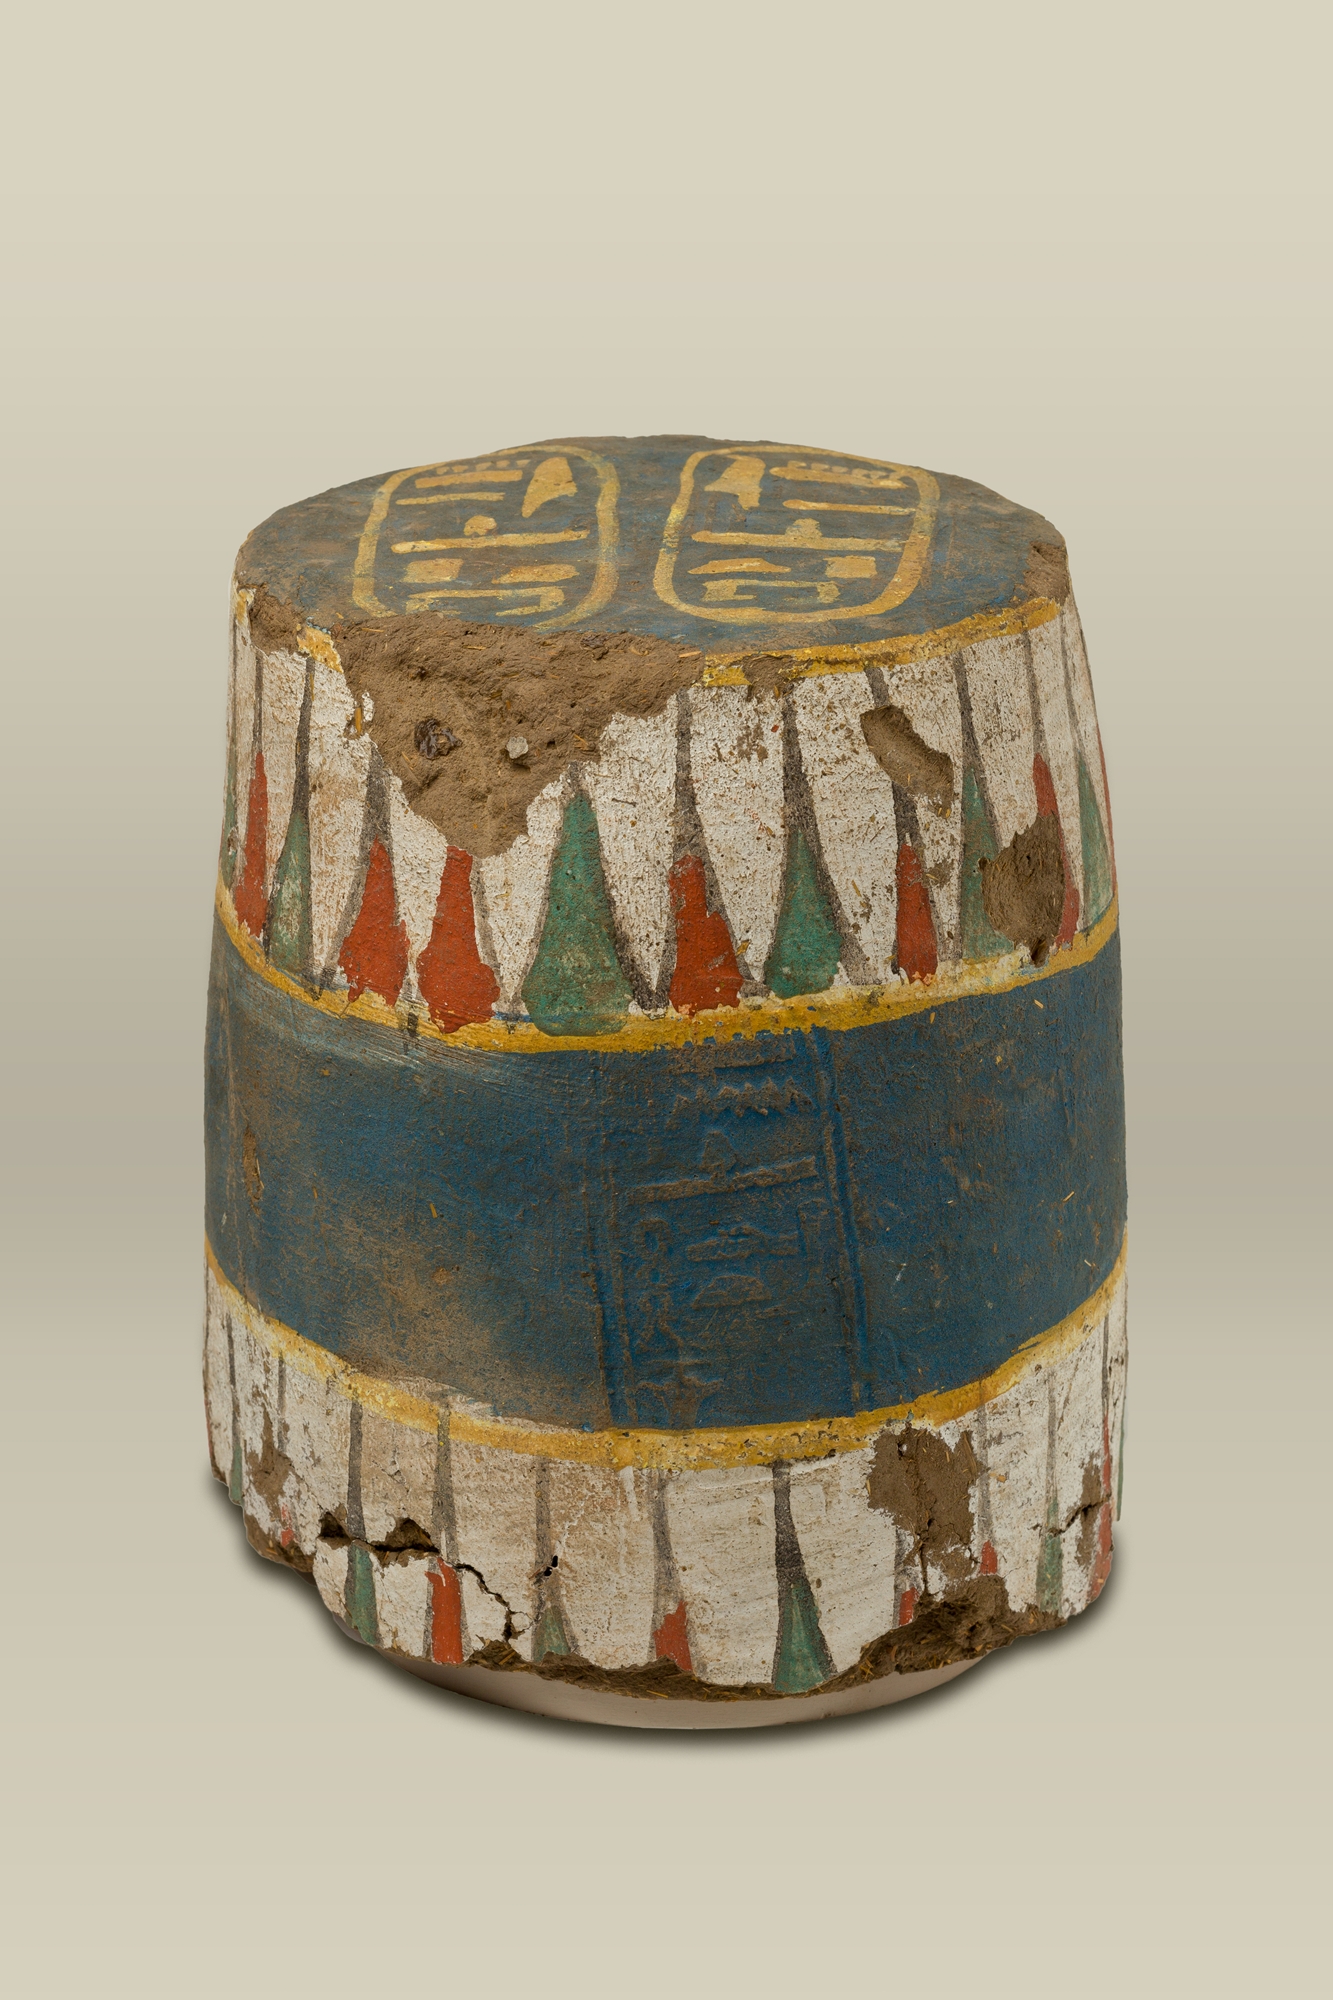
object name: jar sealing, amenhotep iii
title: Sealing from a Jar with the Name of a king Amenhotep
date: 1360 BCE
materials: mud, paint, pottery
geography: upper egypt; thebes